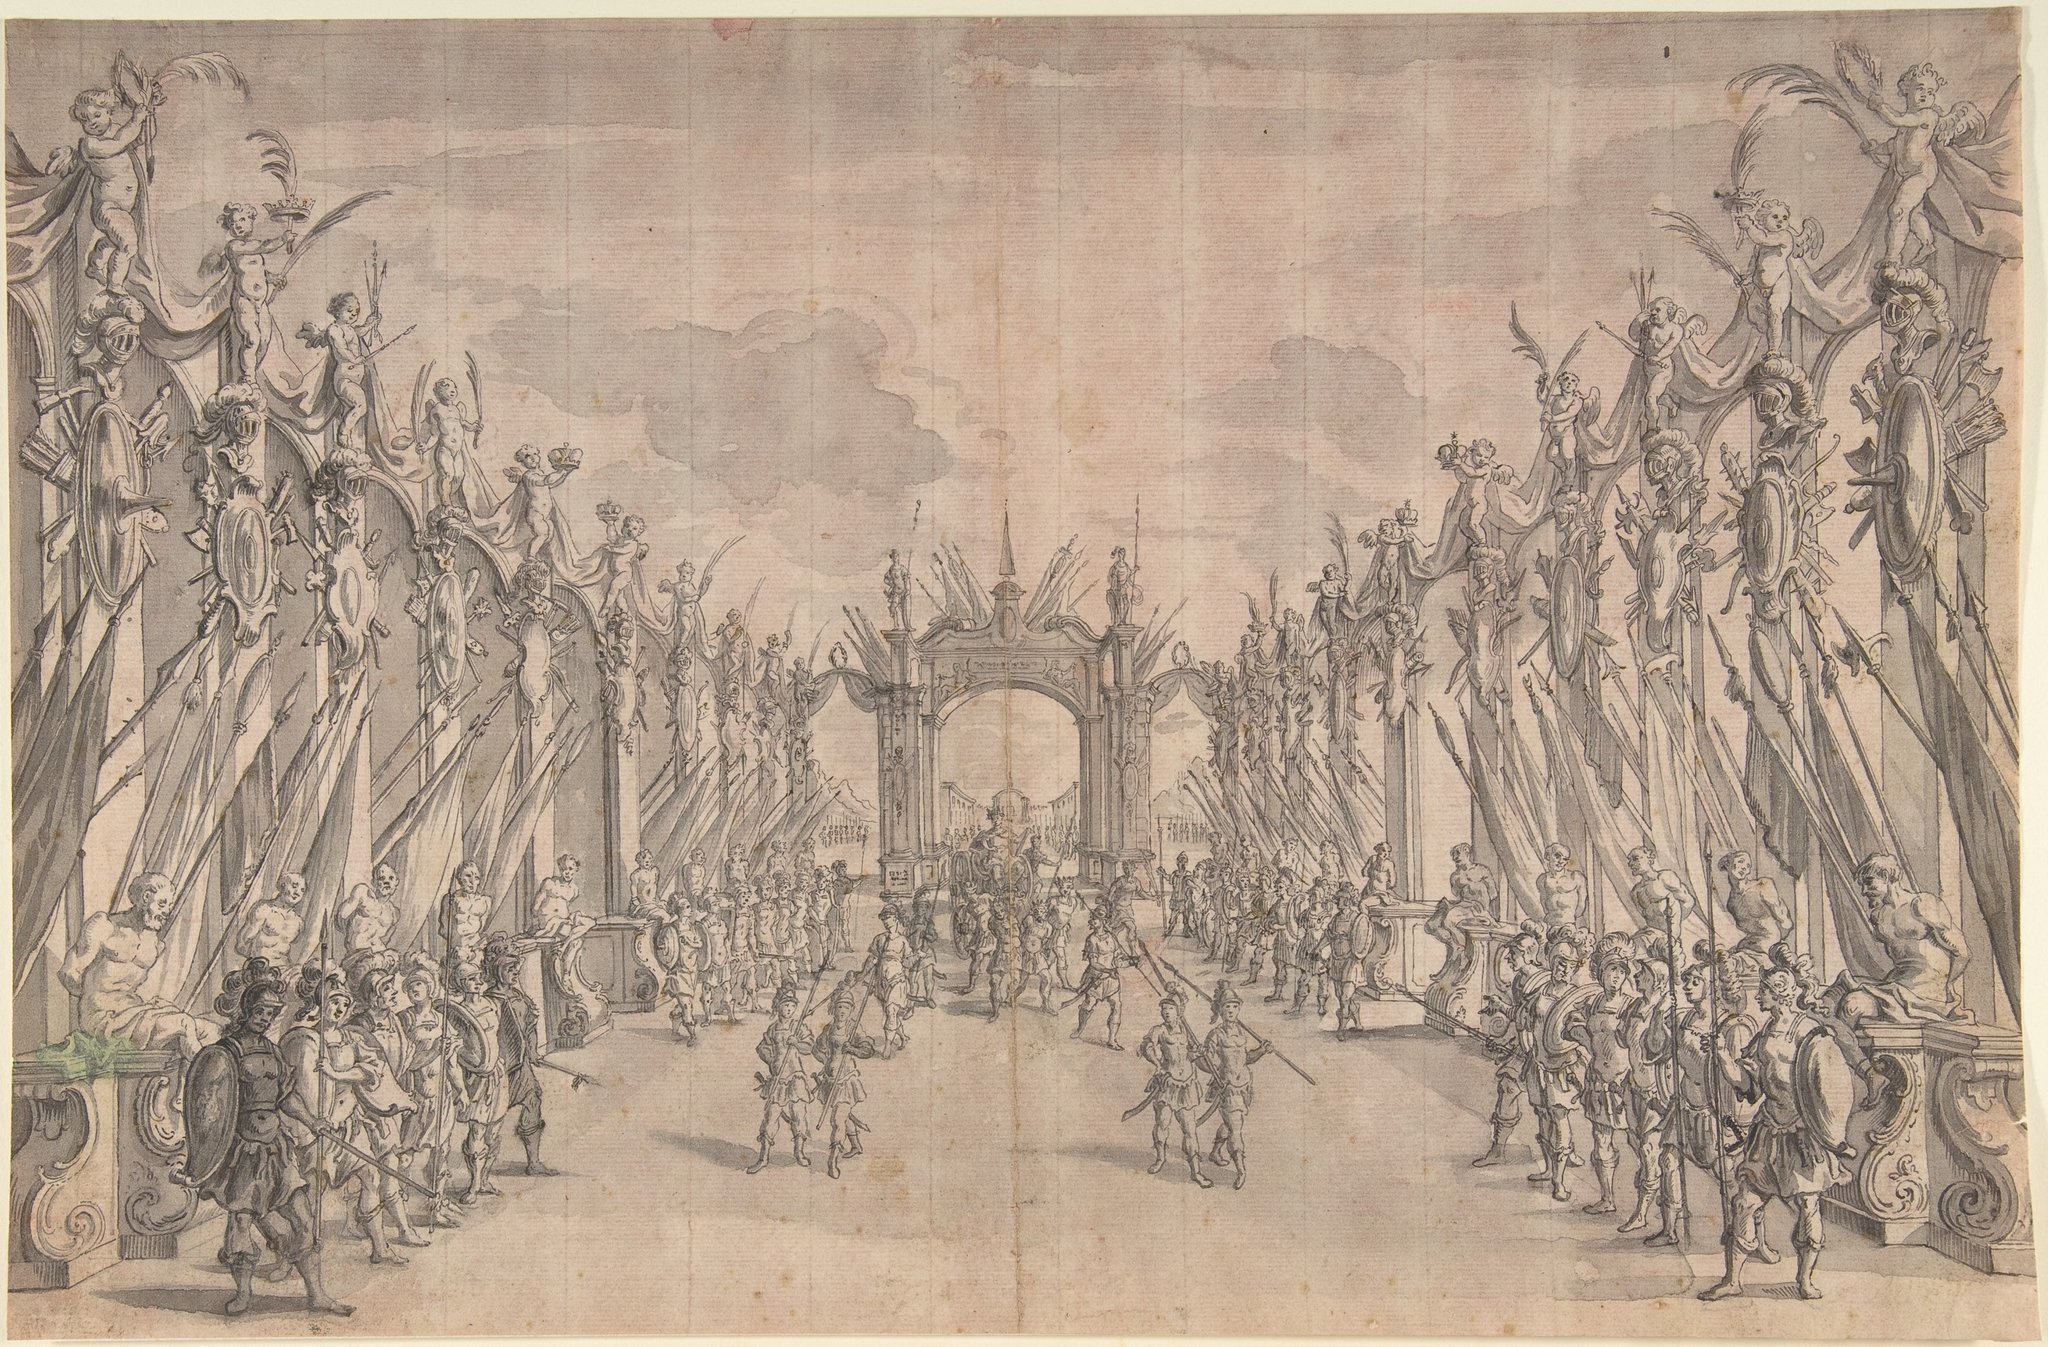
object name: collection ornament architecture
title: Triumphal Entry of King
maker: anonymous, german, 17th century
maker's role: artist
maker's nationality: german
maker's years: 1600-1700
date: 1601-1700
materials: ink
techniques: brush, pen, wash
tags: soldiers,shields,weapons,spears,kings